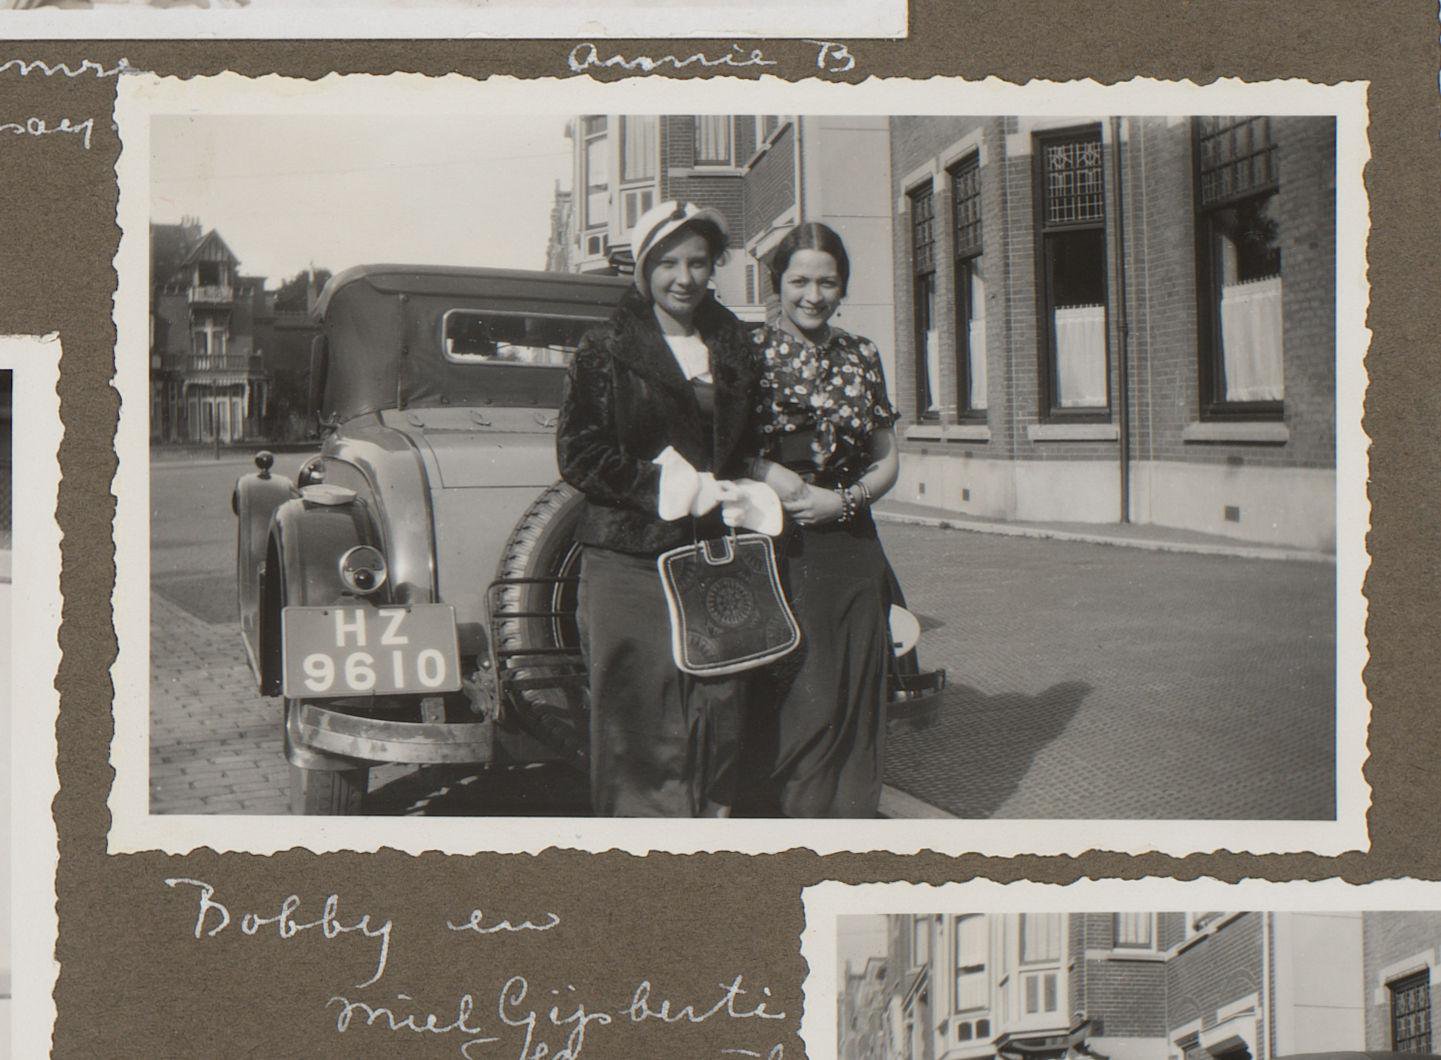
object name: photograph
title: Wilhelmina van Zijll de Jong en een andere vrouw bij een auto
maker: Anonymous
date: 1933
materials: paper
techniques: gelatin silver print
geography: the hague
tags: wilhelmina van zijll de jong, historical persons - bb - woman, automobile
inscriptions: inscription: ‘Bobby en/ Miel Gijsberti/ Hodenpijl’